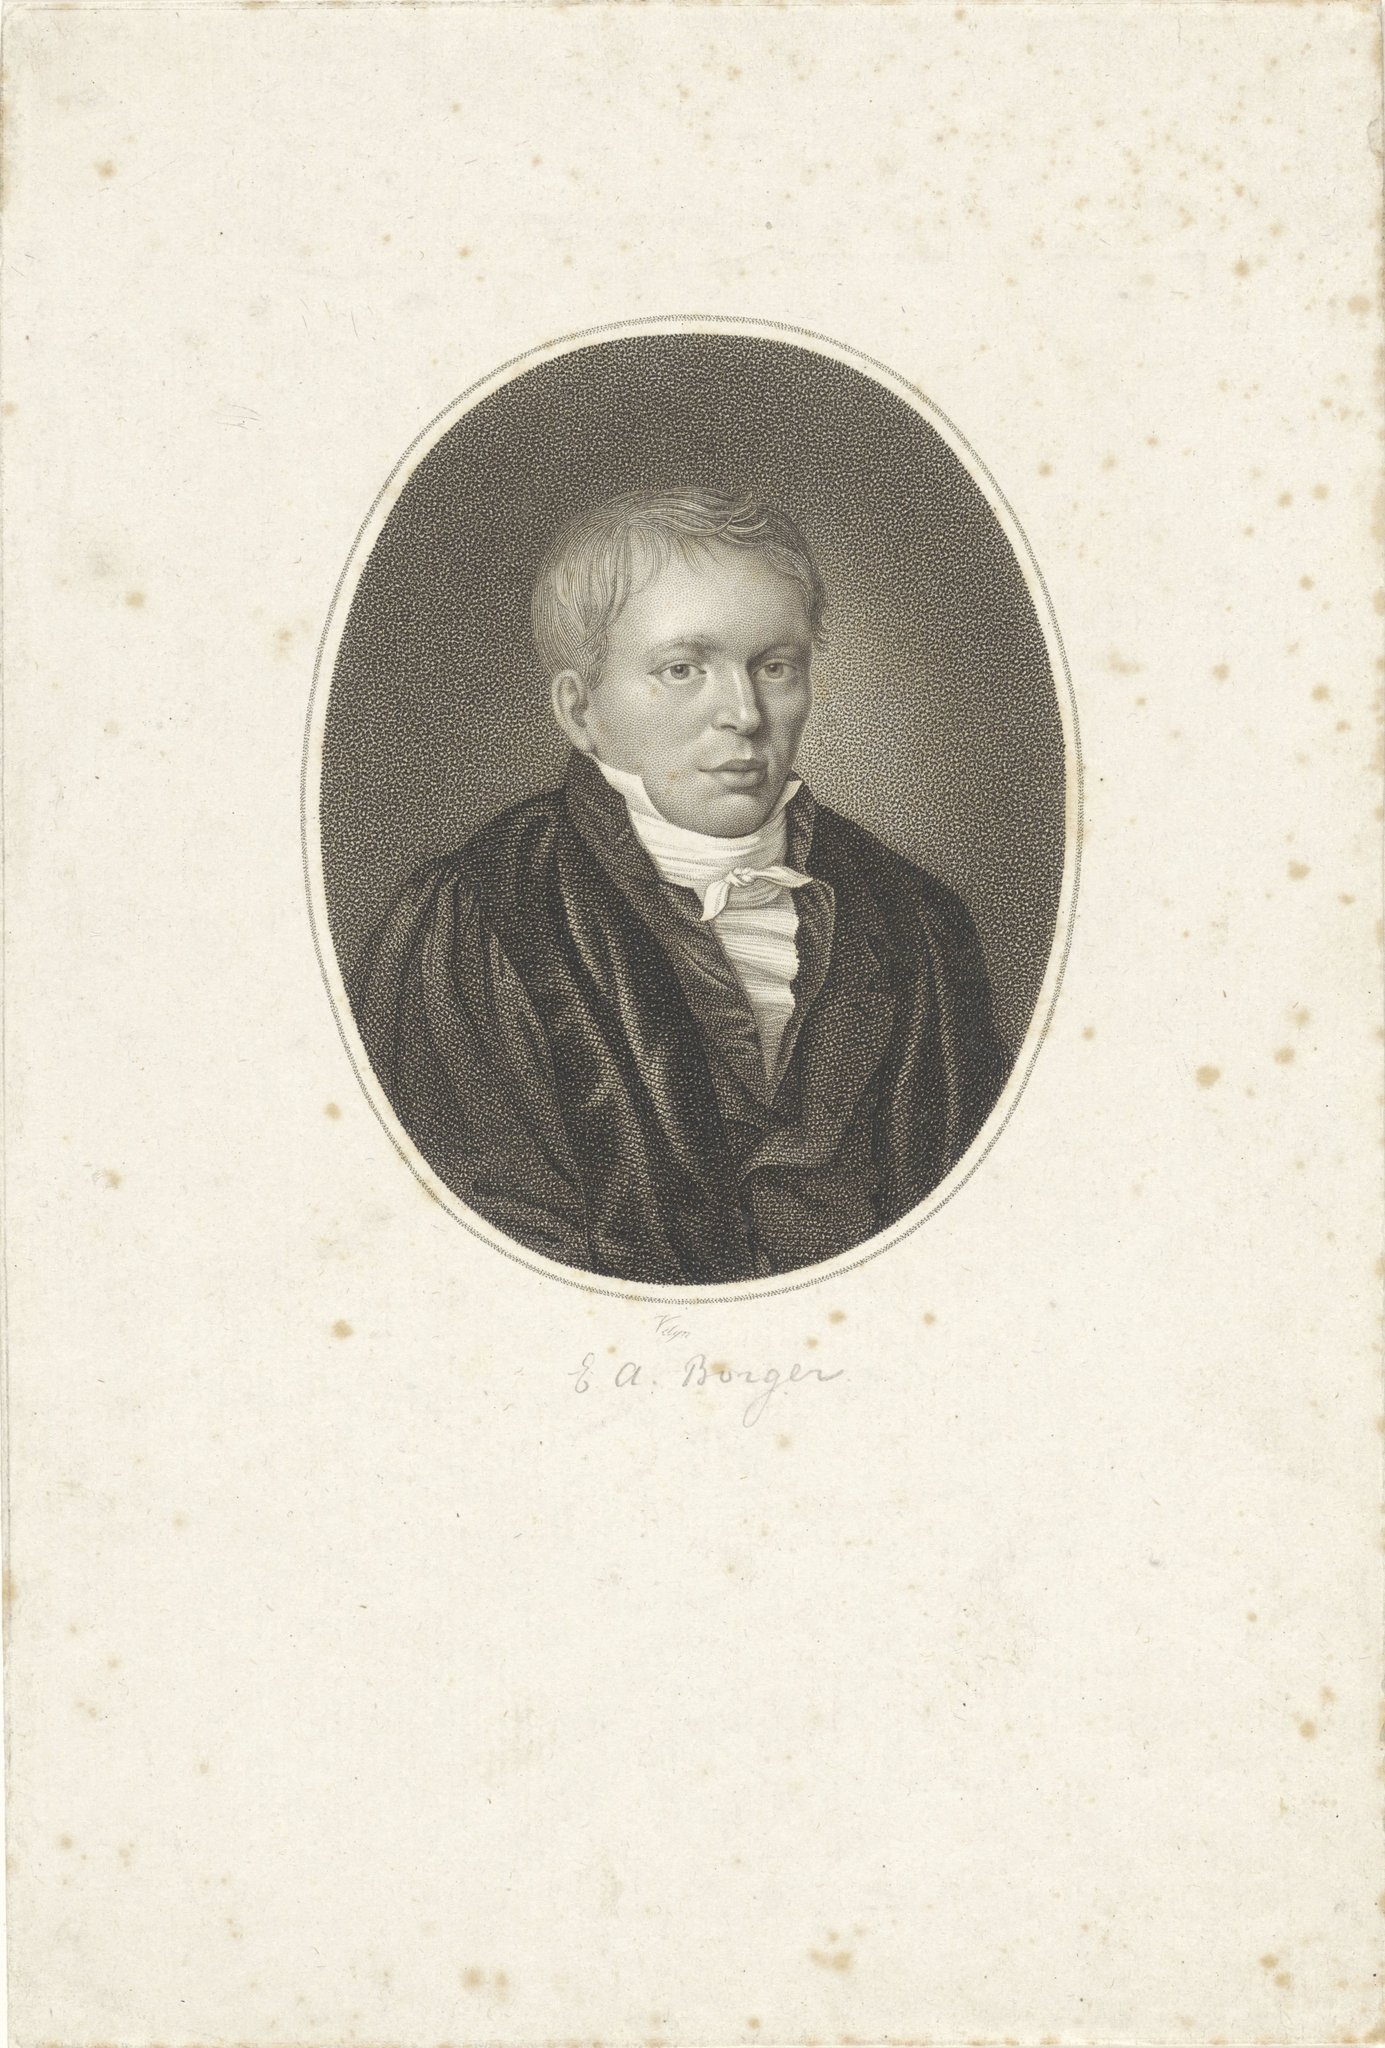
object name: print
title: Portret van Elias Annes Borger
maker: philippus velijn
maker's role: print maker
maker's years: 1787-1836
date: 1797-1836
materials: paper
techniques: engraving, etching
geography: netherlands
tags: joure, dichter, elias annes borger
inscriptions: collector's mark: Lugt 2228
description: Portret van Nederlandse dichter en hoogleraar Elias Annes Borger.